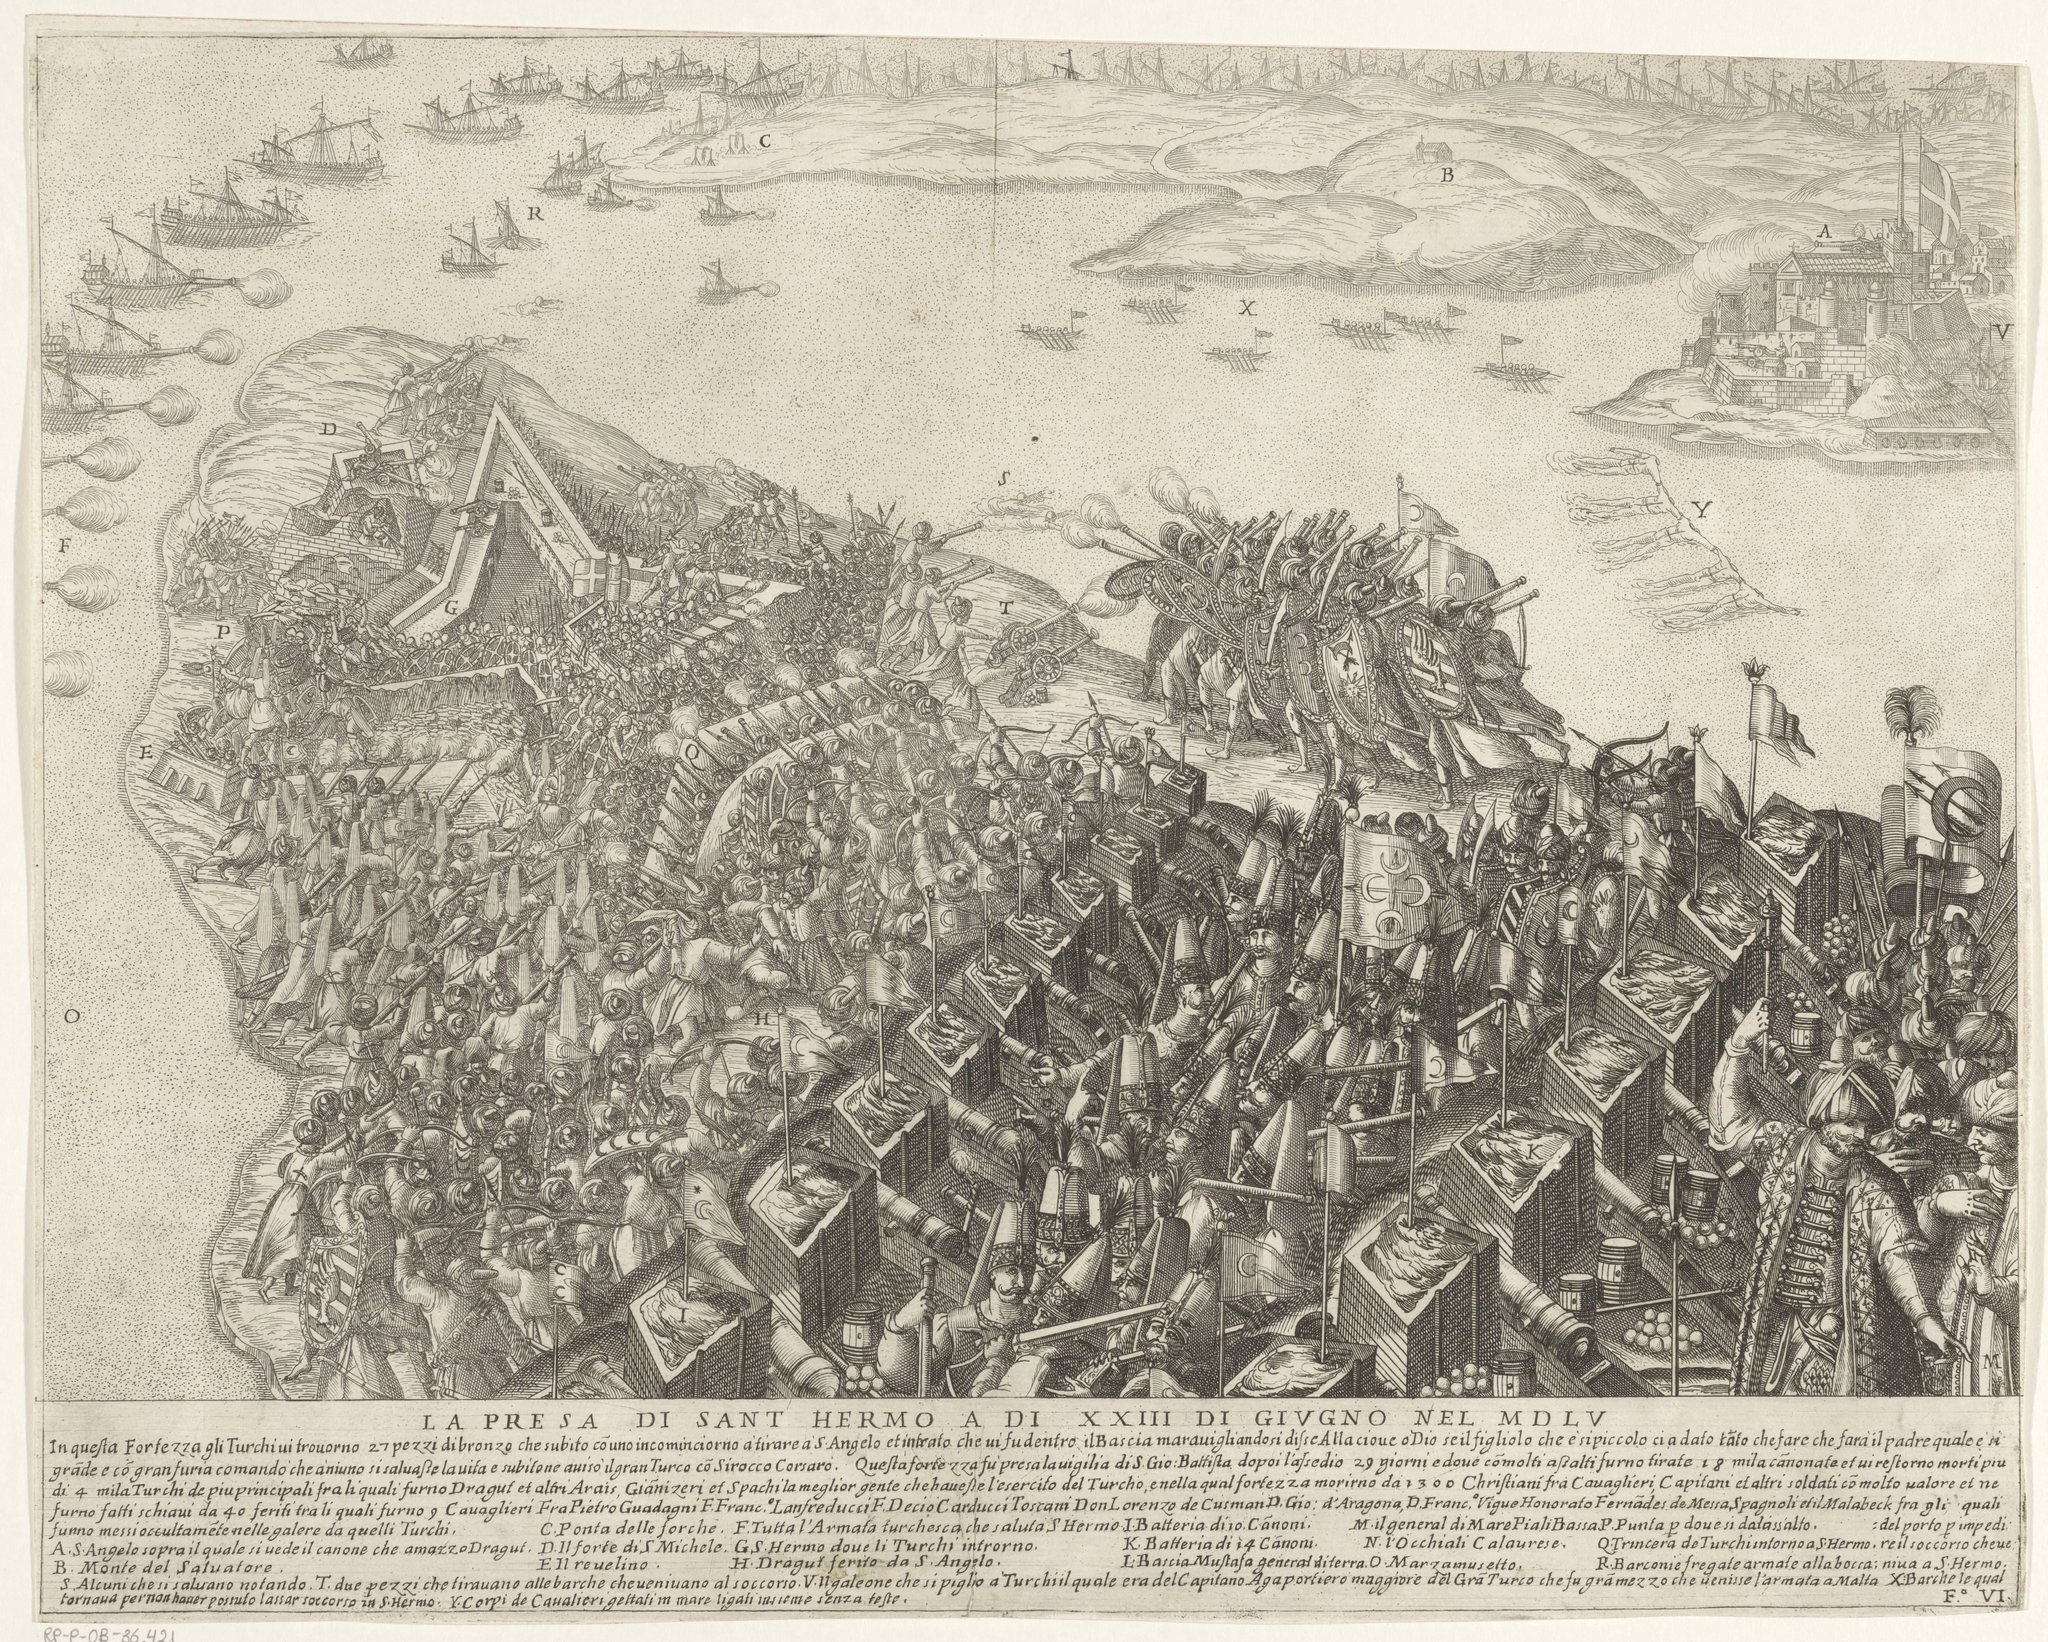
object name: print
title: Inname van Sant Hermo op Malta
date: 1665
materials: paper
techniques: etching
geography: italy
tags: island, asiatic races and peoples: turks, battle (+ naval force), the soldier; the soldier's life, battle (+ land forces)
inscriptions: collector's mark: Lugt 2228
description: De inname van Sant Hermo op Malta. Turkse soldaten in strijd met Maltezer soldaten op het land en op het water. Italiaanse tekst en verklarende lijst met nummers in ondermarge. Genummerd rechtsonder: Fo. VI.